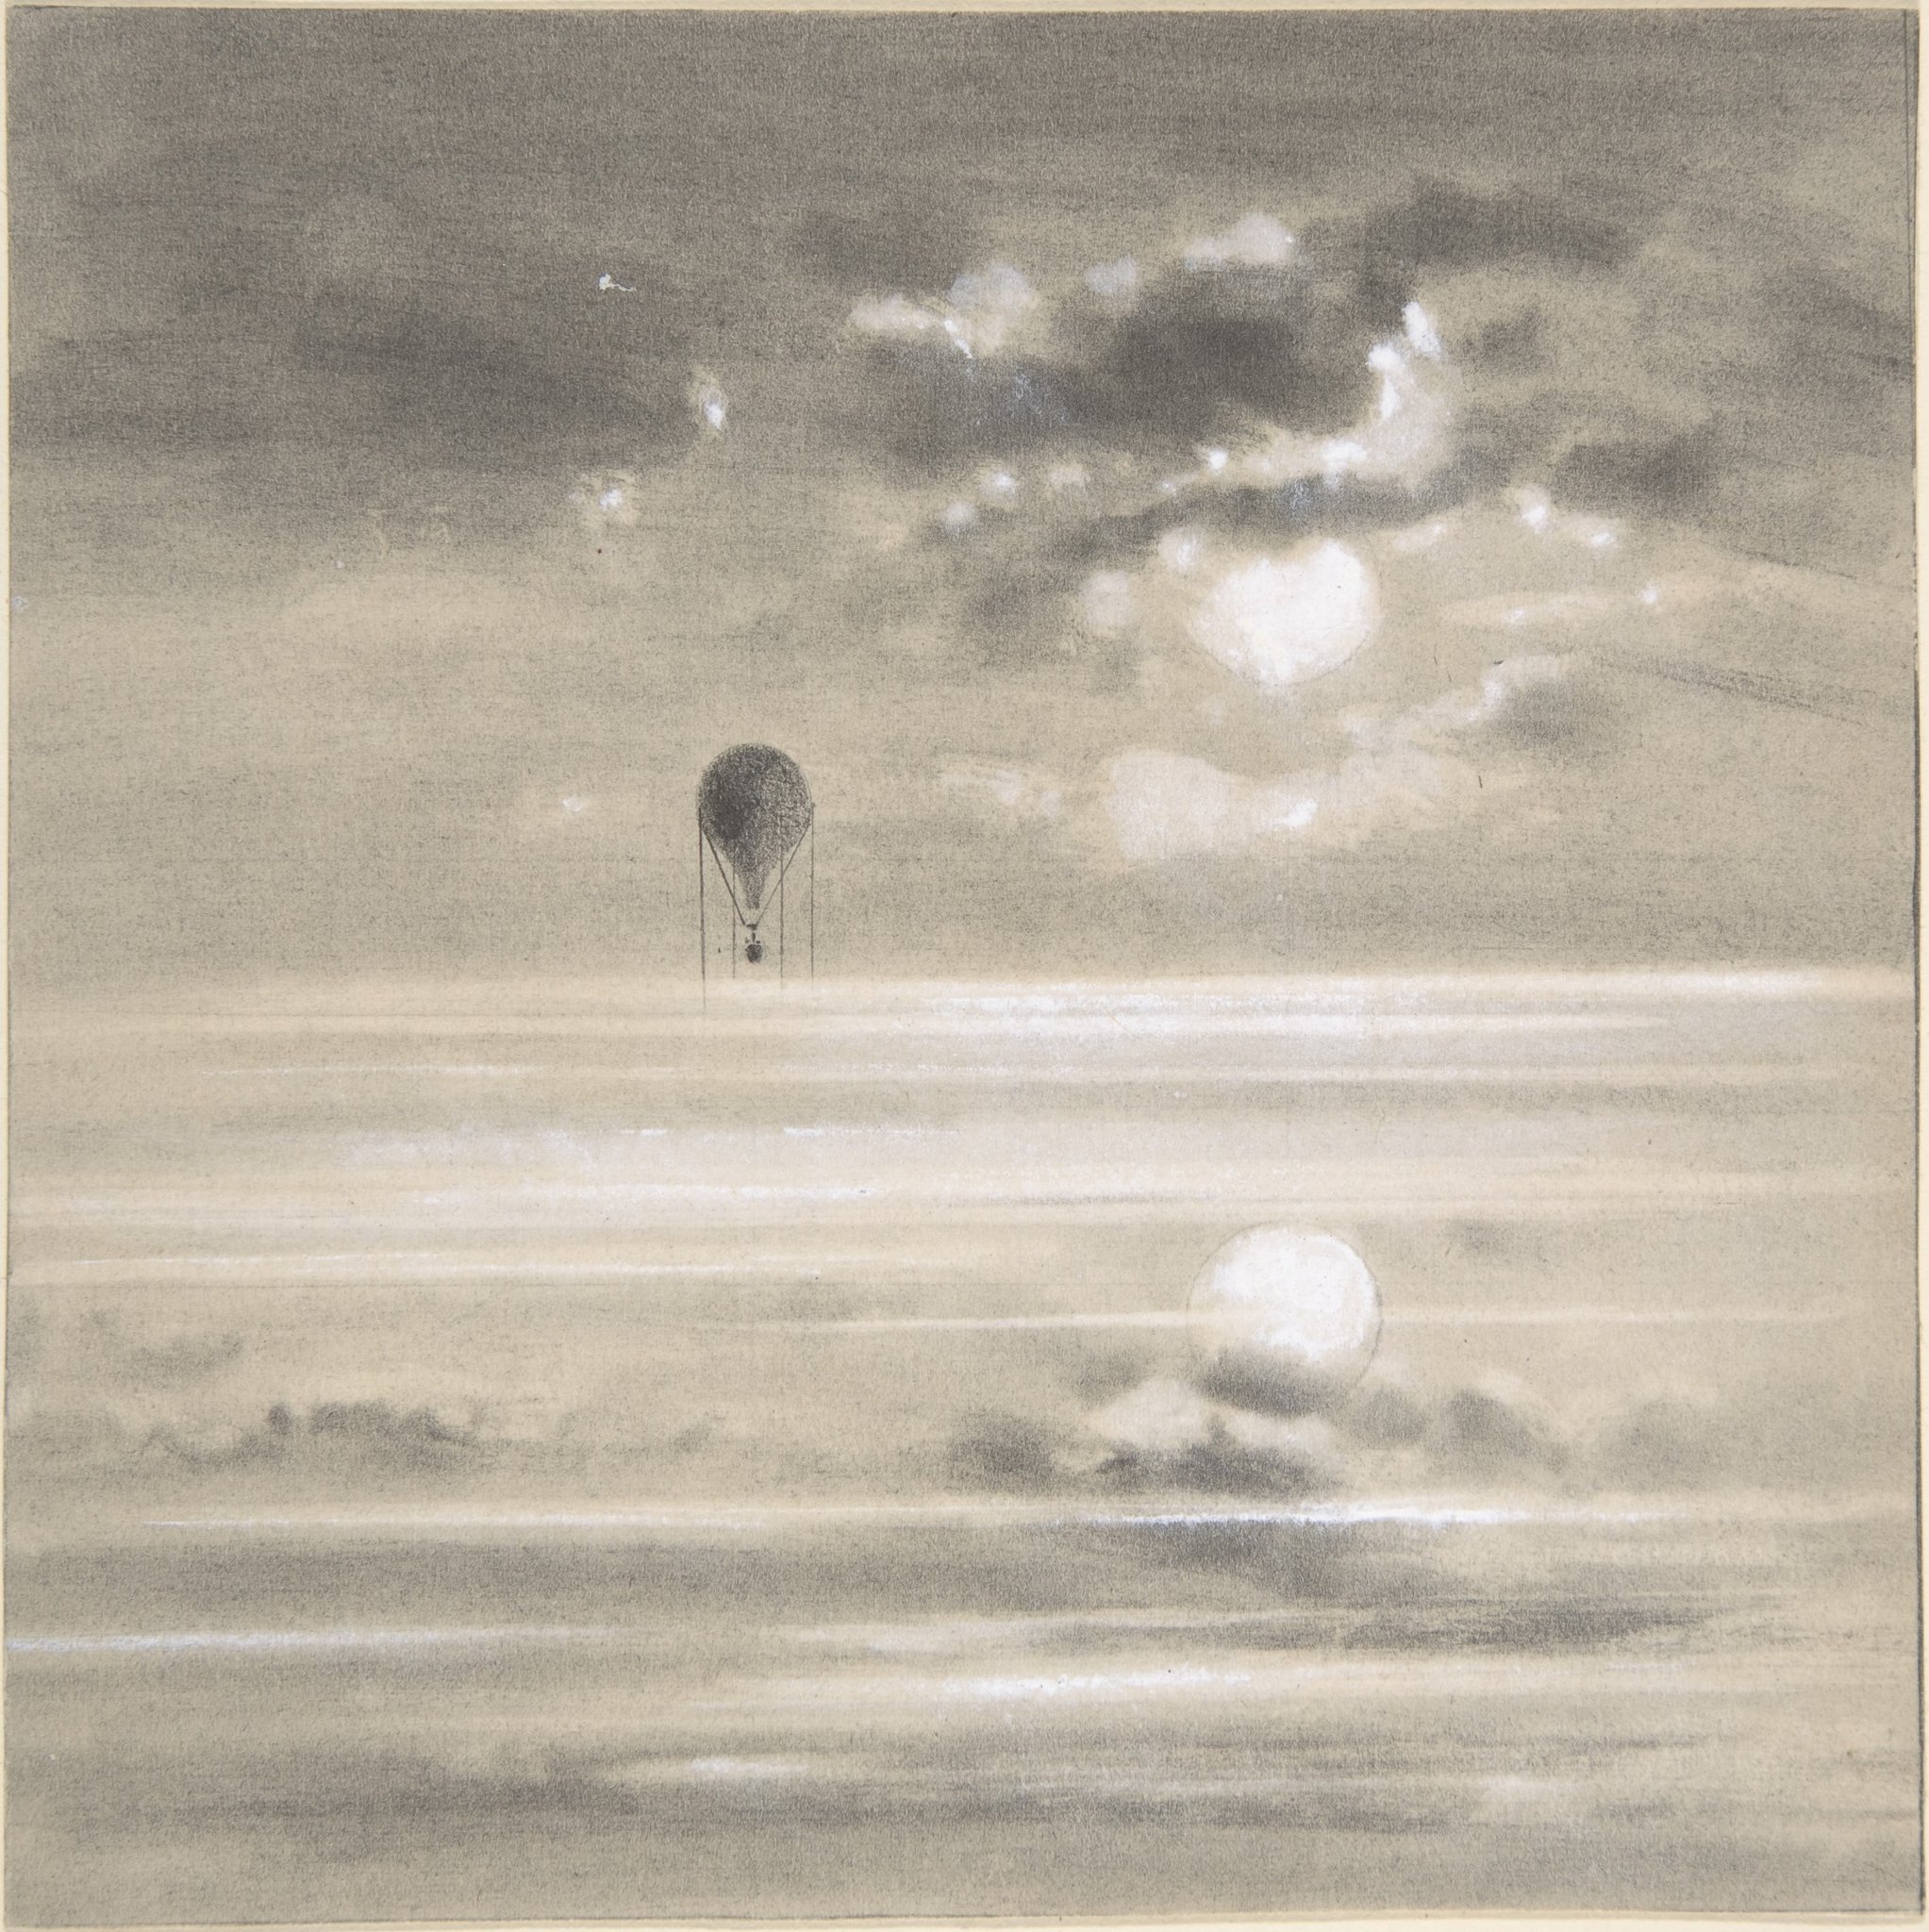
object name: drawing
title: Drawing for an Illustration in "Voyages du Flandre"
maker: albert-charles tissandier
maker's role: artist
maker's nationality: french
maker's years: 1839-1906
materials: graphite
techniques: brush, wash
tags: hot air balloons